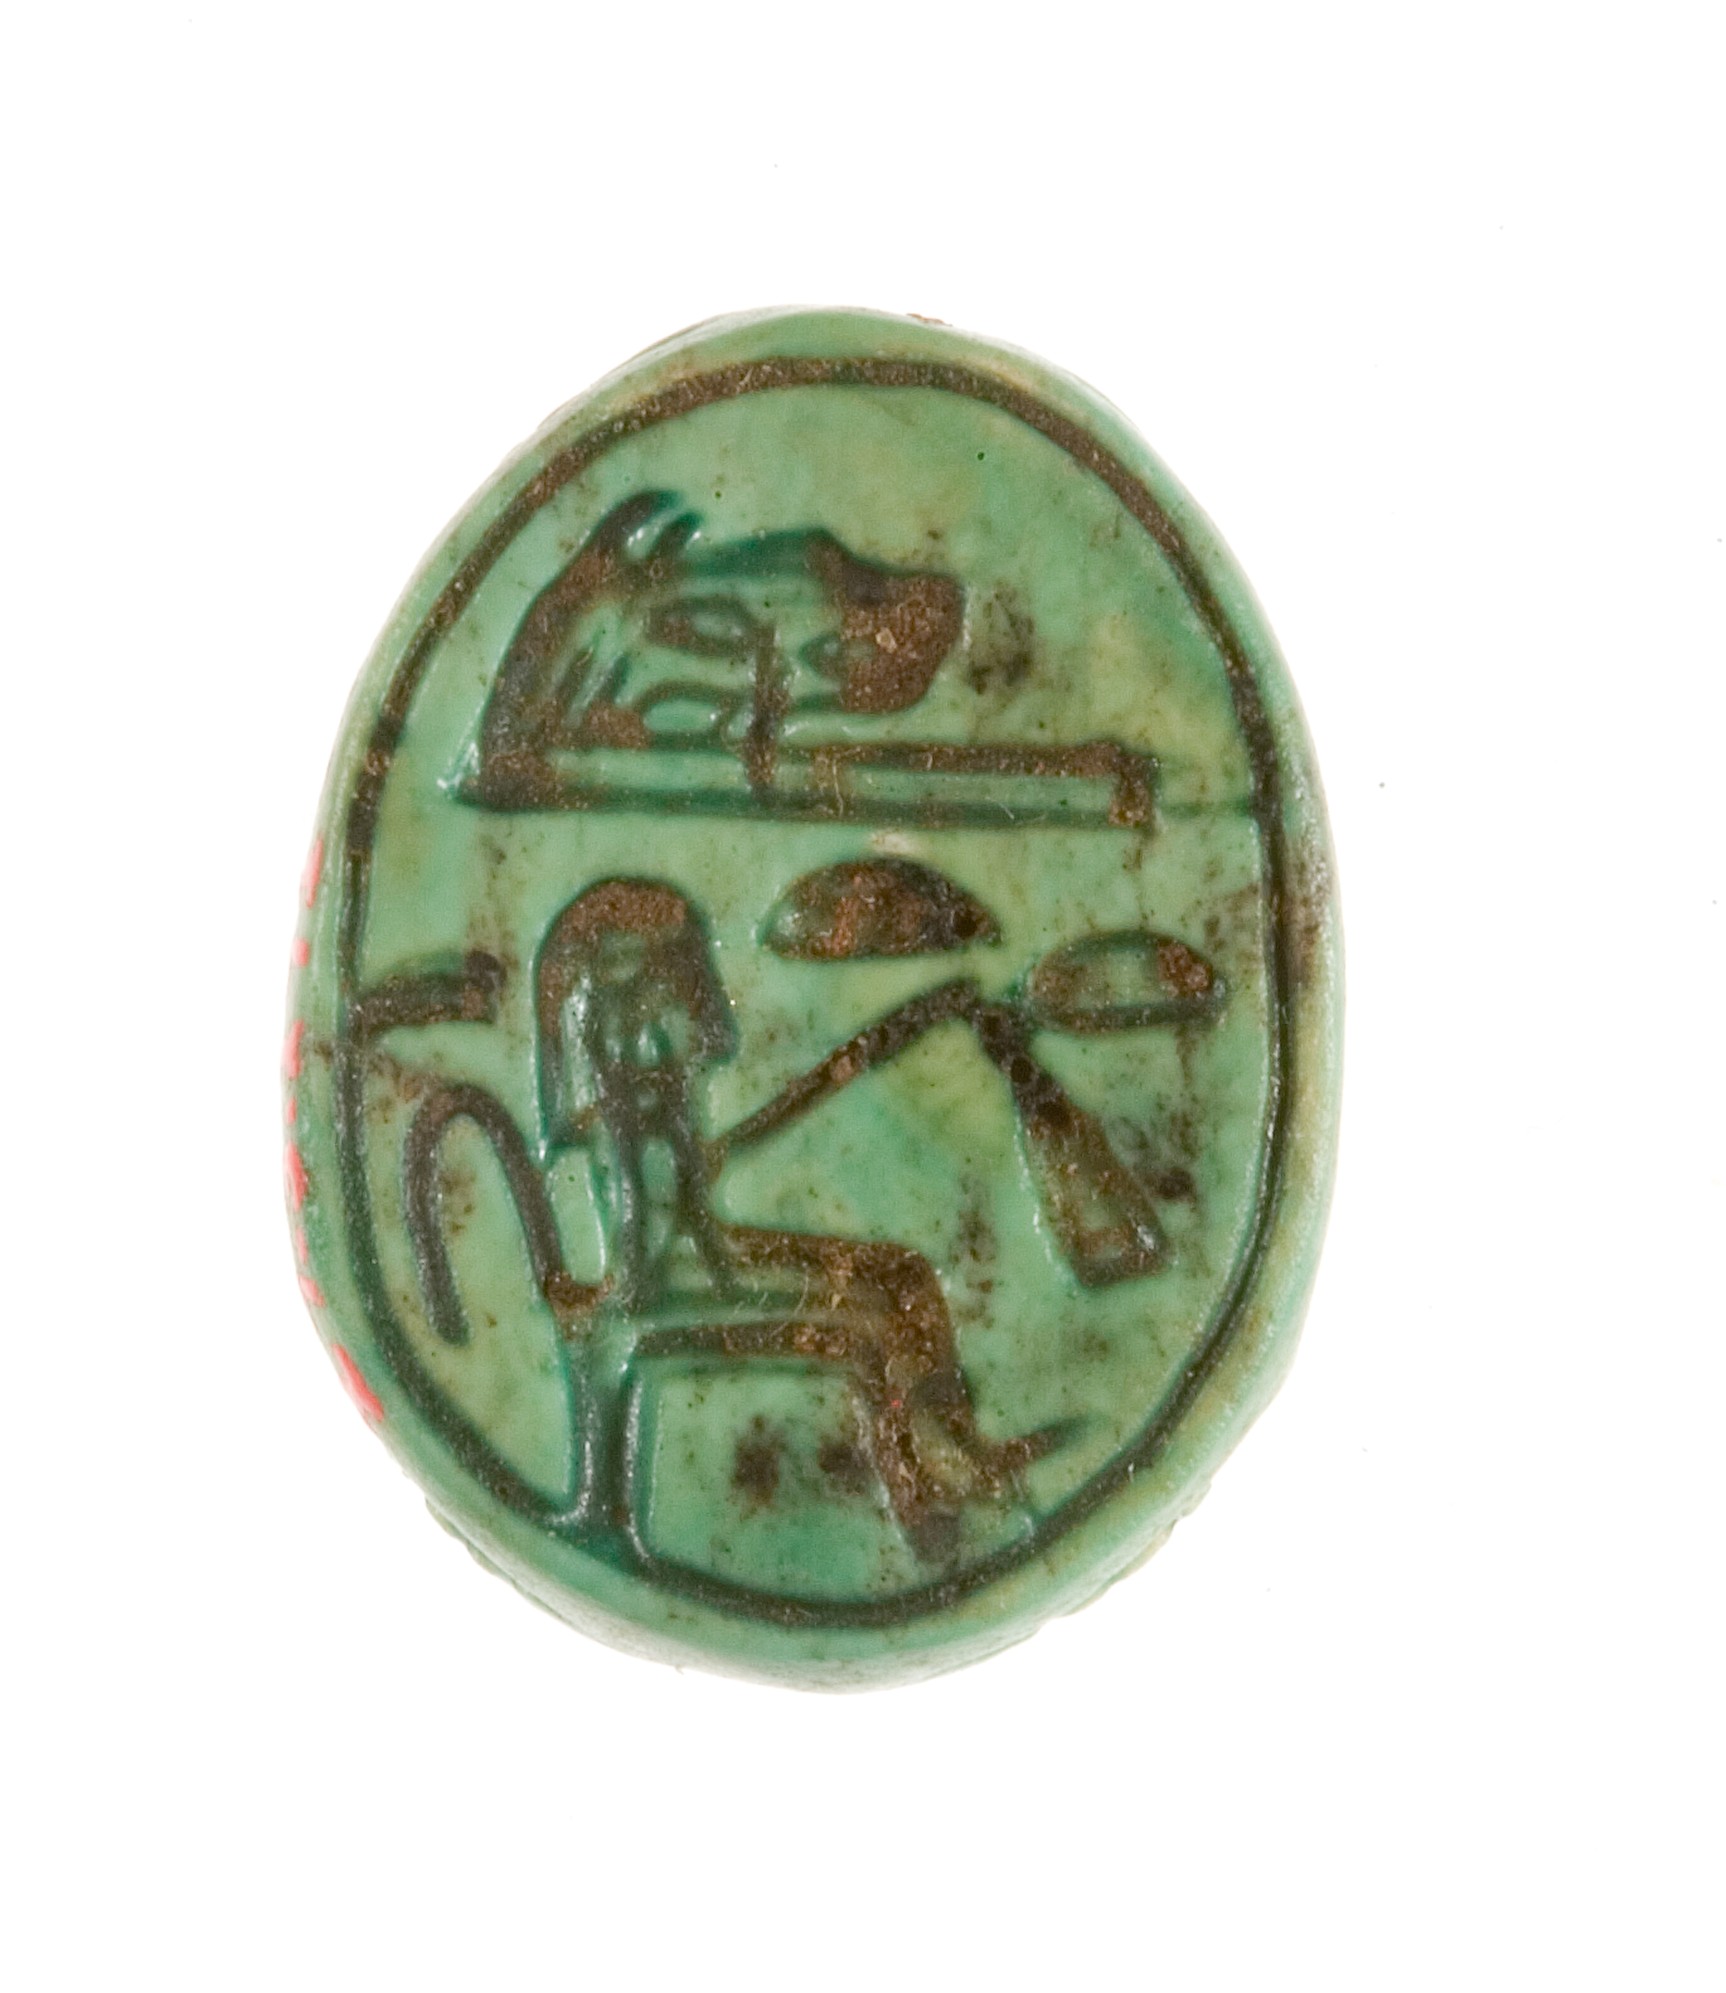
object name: scarab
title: Scarab Inscribed for Hatshepsut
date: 1479-1458 BCE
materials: stone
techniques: glazing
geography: egypt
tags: hieroglyphs,scarabs